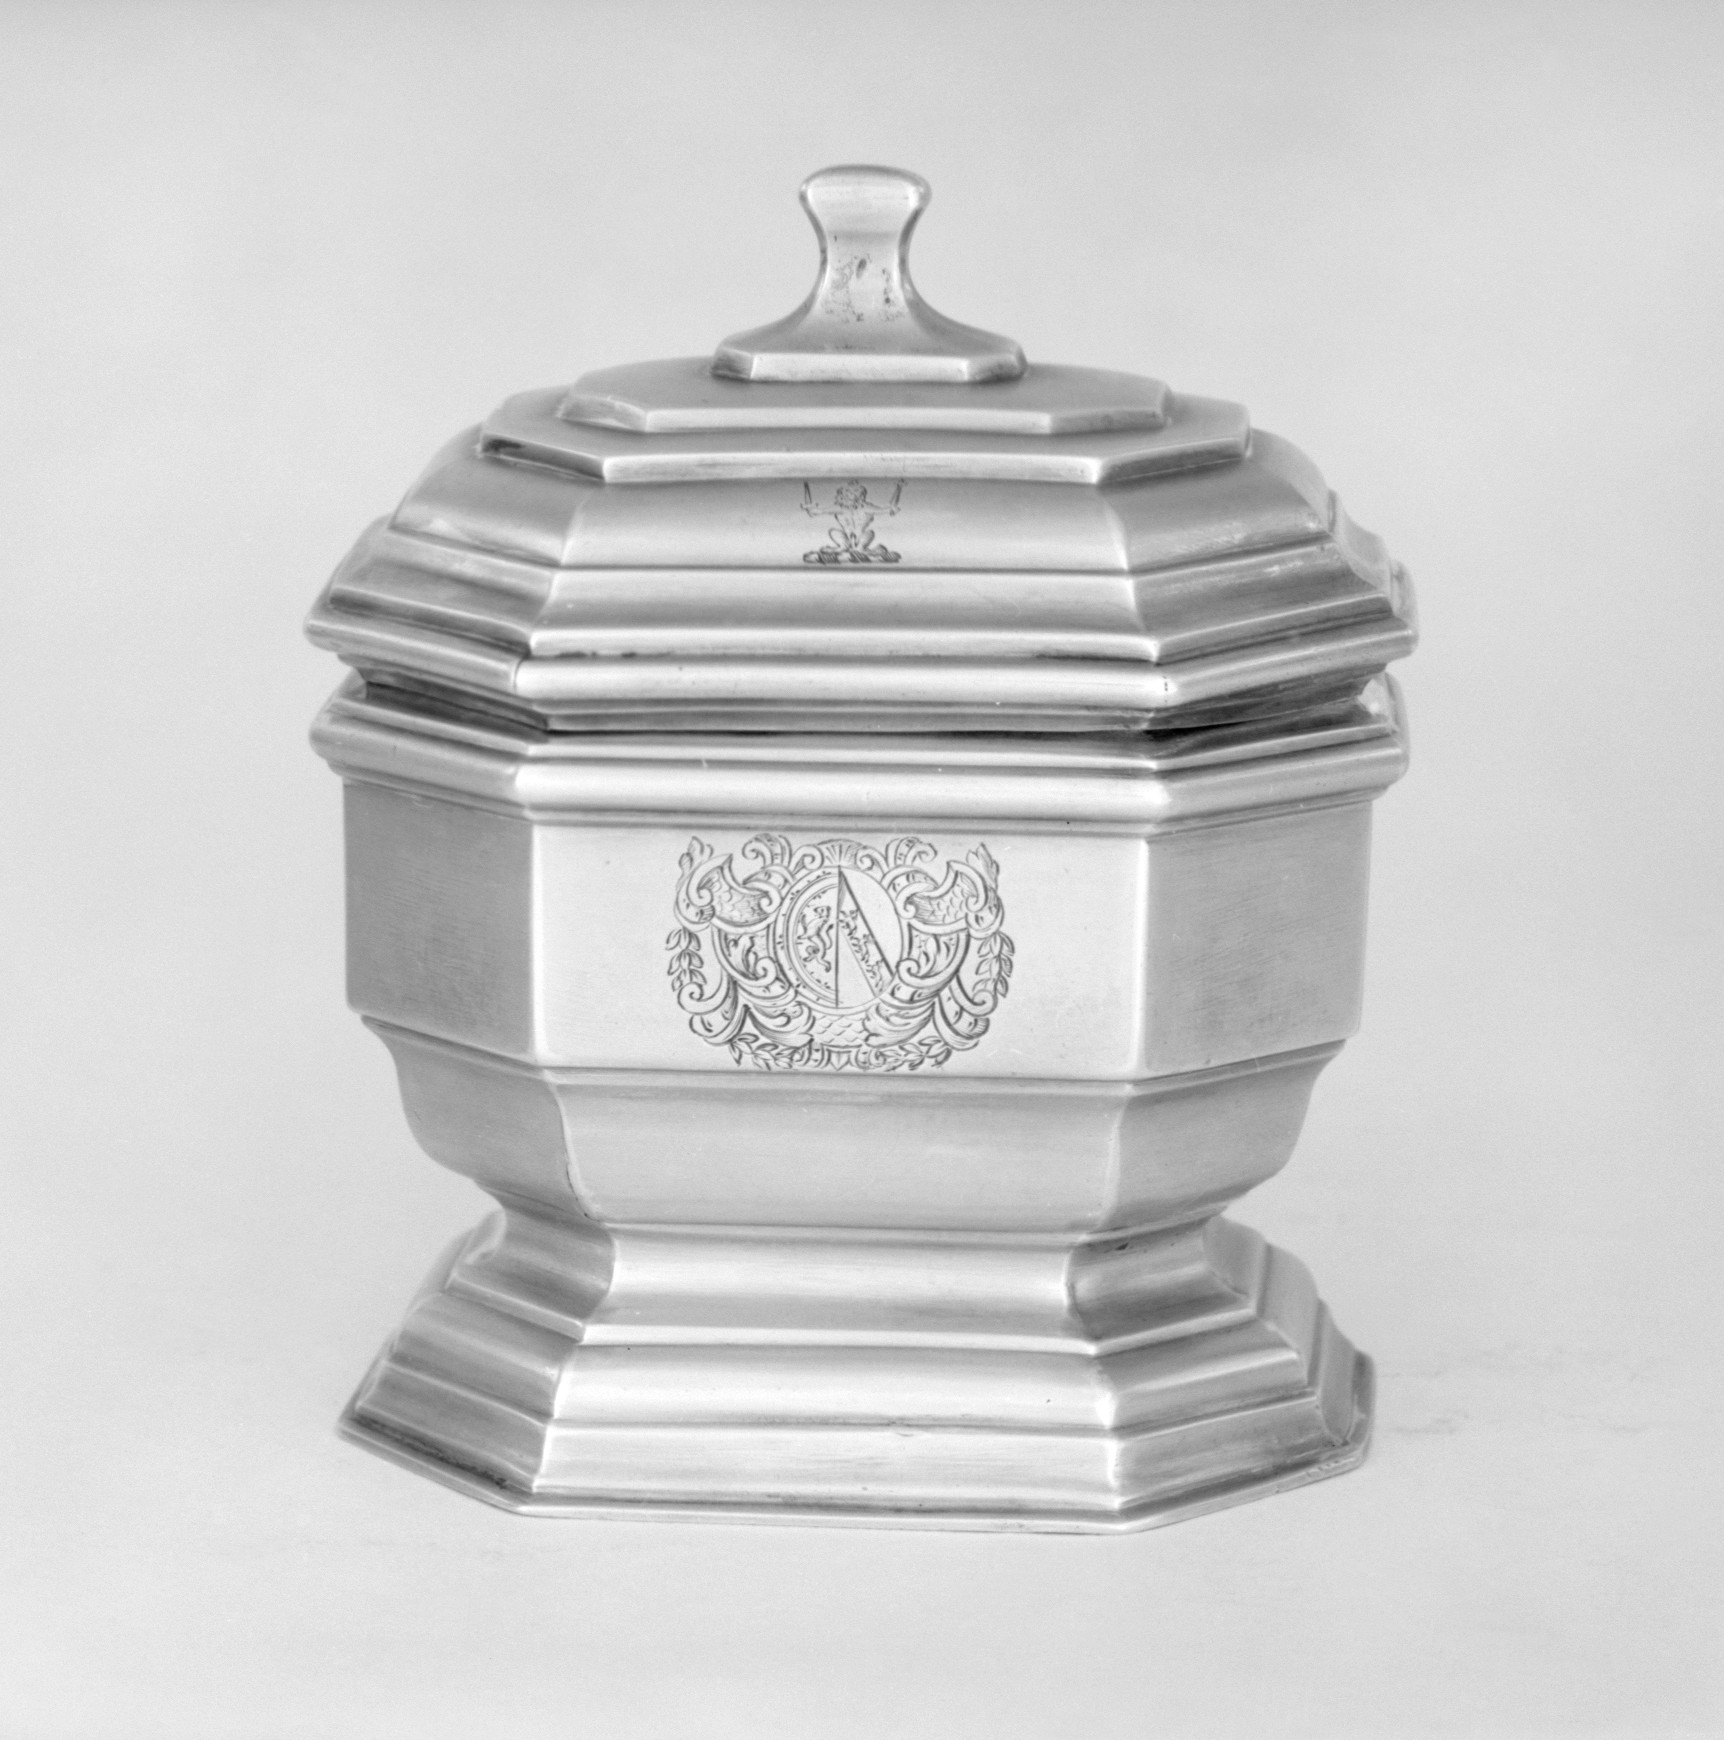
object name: sugar box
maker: ebenezer roe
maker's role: maker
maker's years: 1709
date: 1711-1712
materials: silver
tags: lions,coat of arms